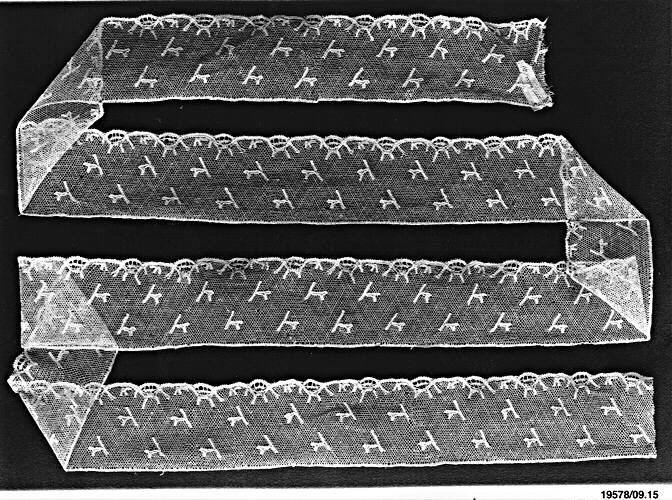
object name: fragment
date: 1801-1833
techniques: lace